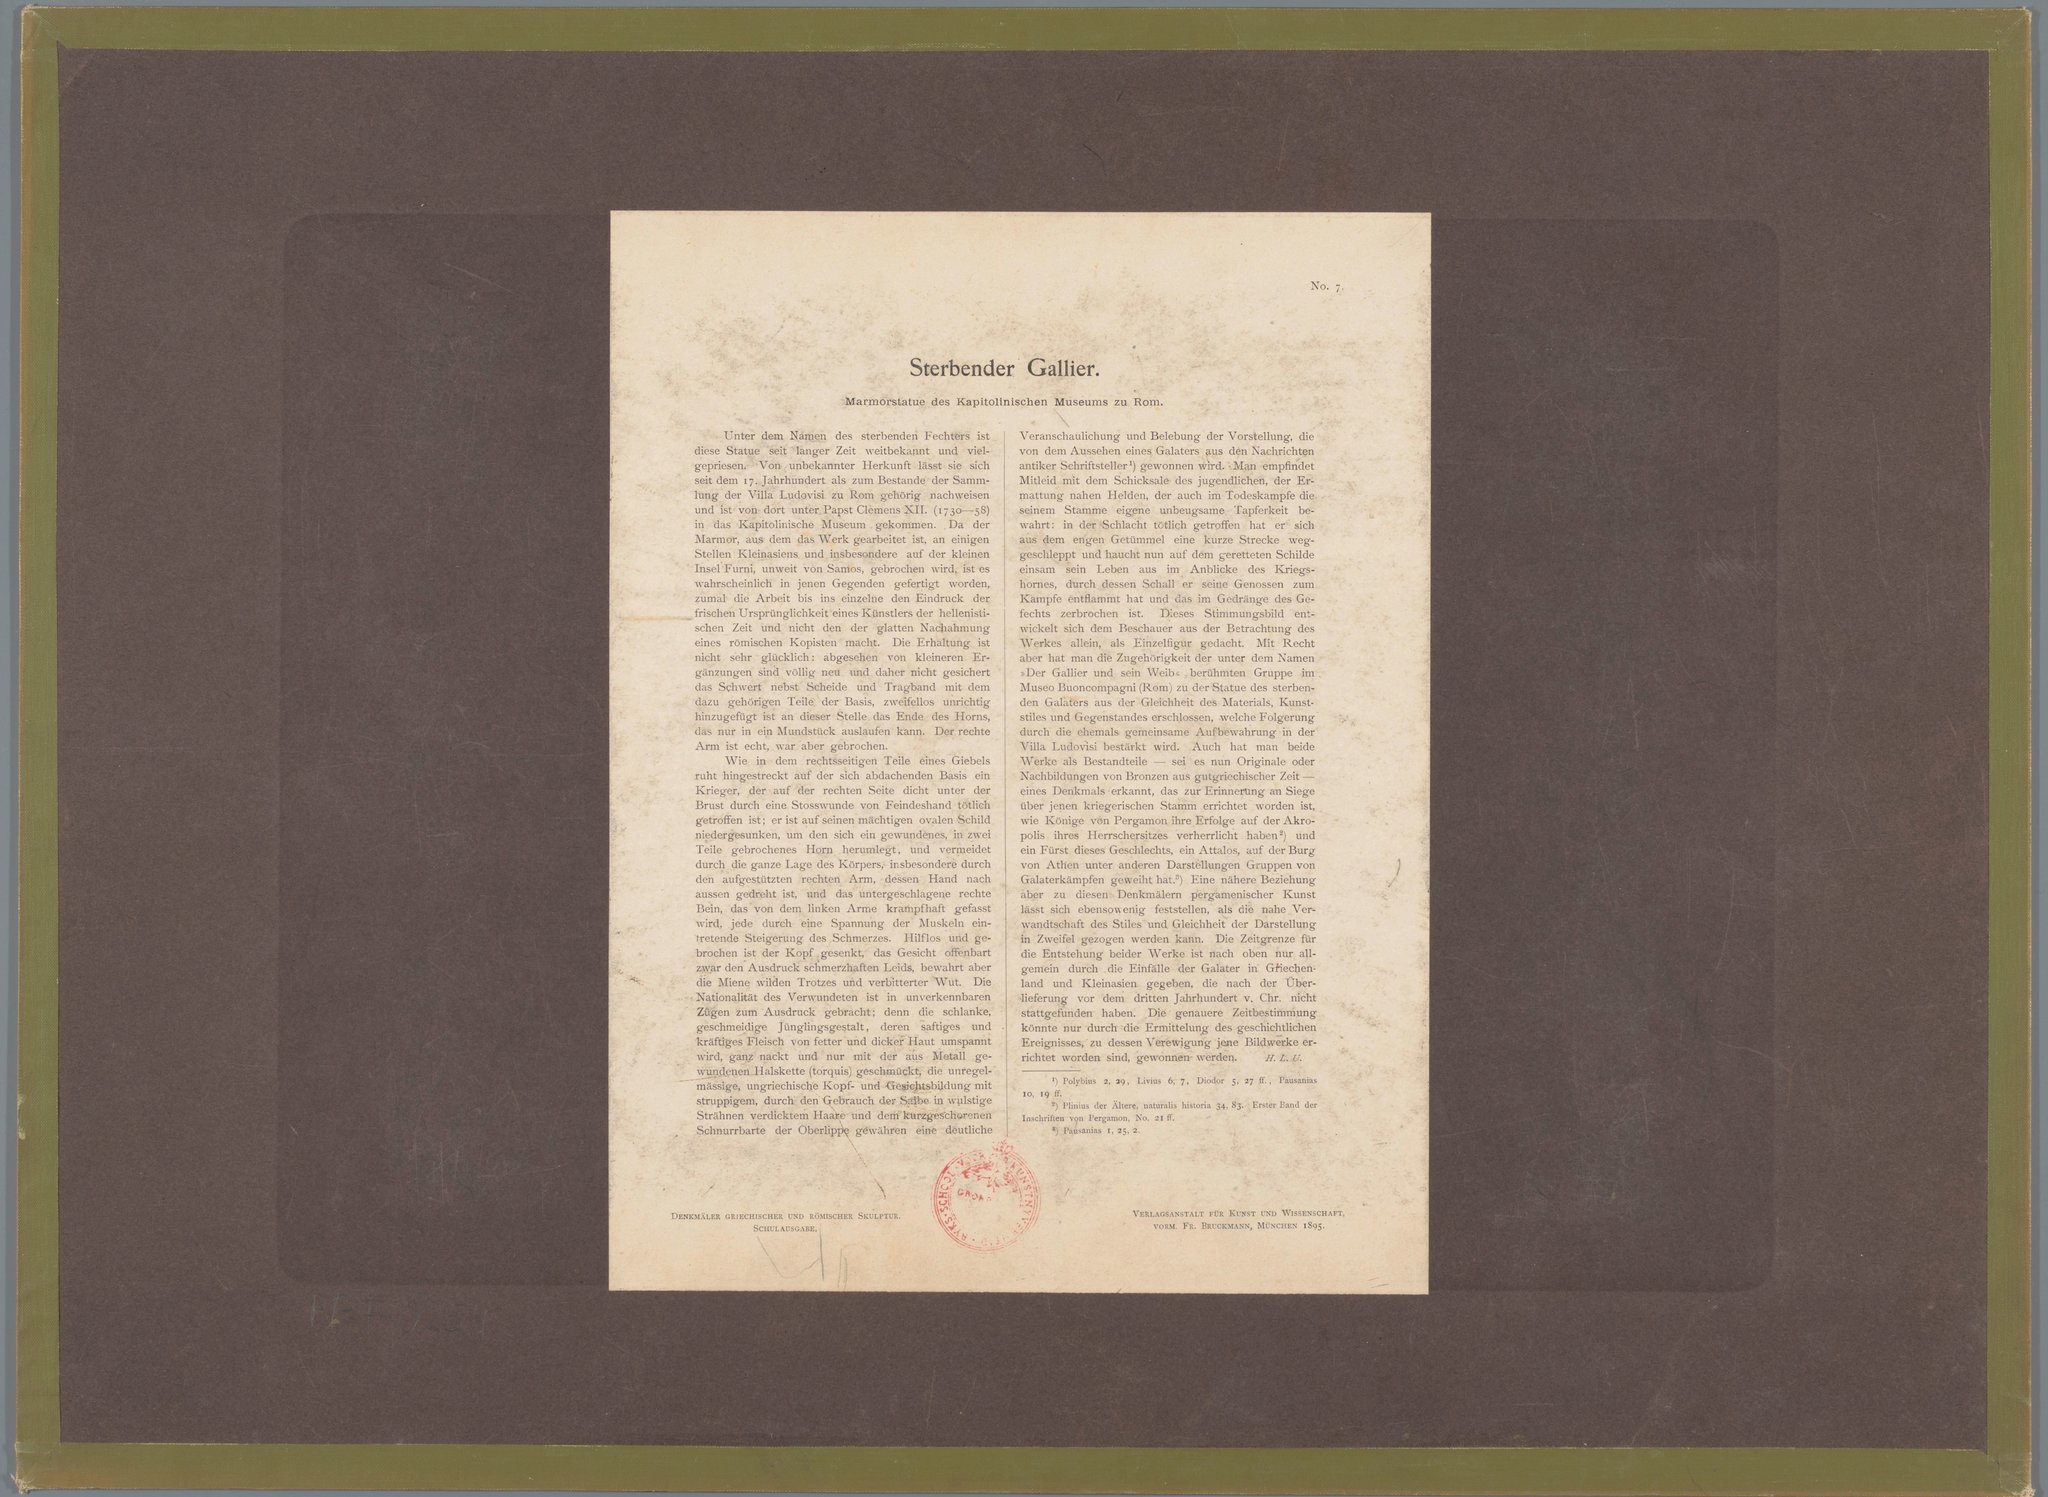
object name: photograph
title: Sterbender Gallier.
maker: Anonymous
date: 1895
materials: cardboard, paper, ink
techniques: photograph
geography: capitolijnse musea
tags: dying, sculpture, extinct, 'historical' peoples: gauls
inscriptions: inscription:, number: ‘No. 7.’, collector's mark: Lugt 3937